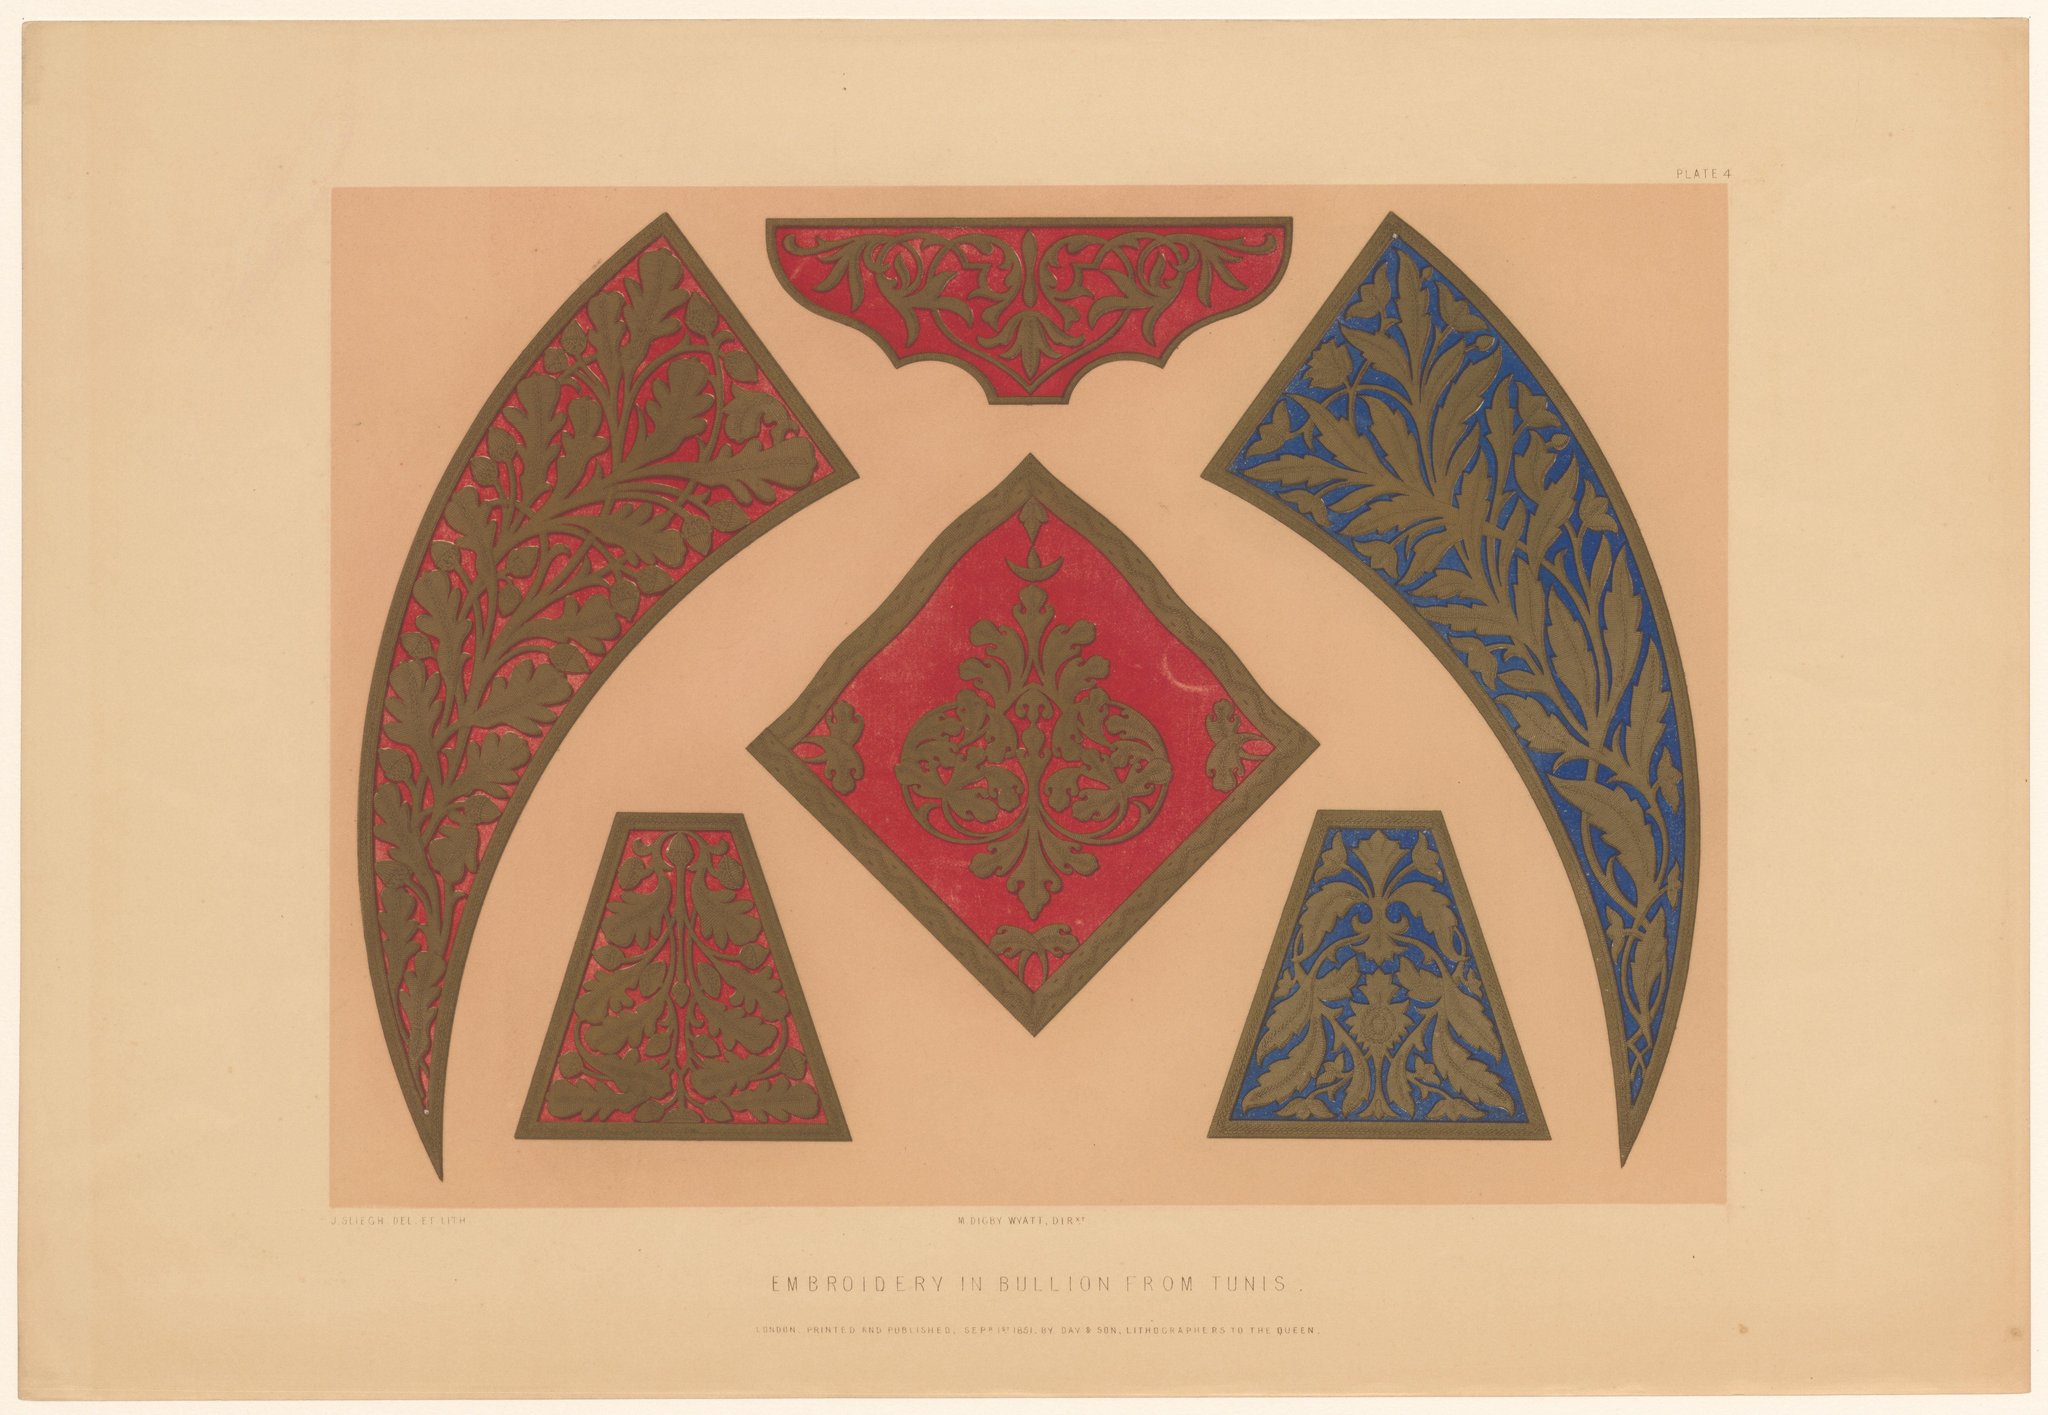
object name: print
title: The industrial arts of the nineteenth century: a series of illustrations of the choicest specimens produced by every nation, at the Great Exhibition of Works of Industry, 1851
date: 1851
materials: paper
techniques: chromolithography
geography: london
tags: flowers ~ ornament - aa - stylized, embroidery (ornamentation)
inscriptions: collector's mark: Lugt 2228